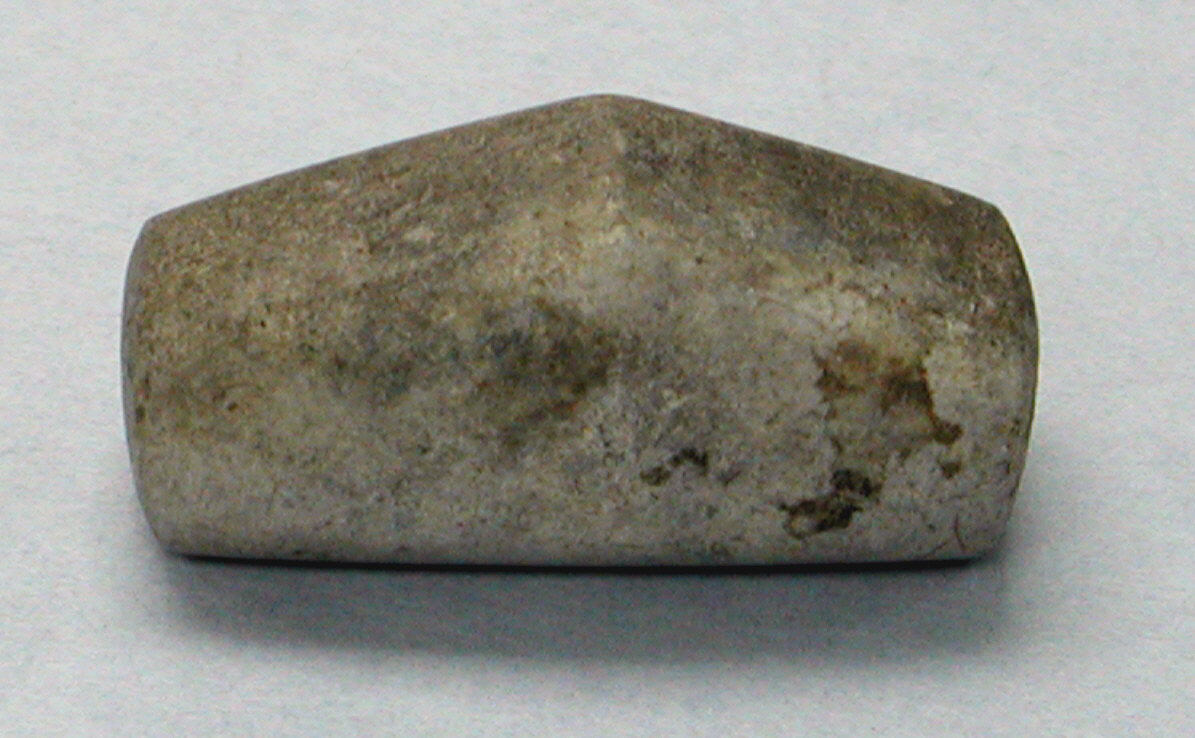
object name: ritual stone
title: Stone Pulidor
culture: mexican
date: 1501-1600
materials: stone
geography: mexico